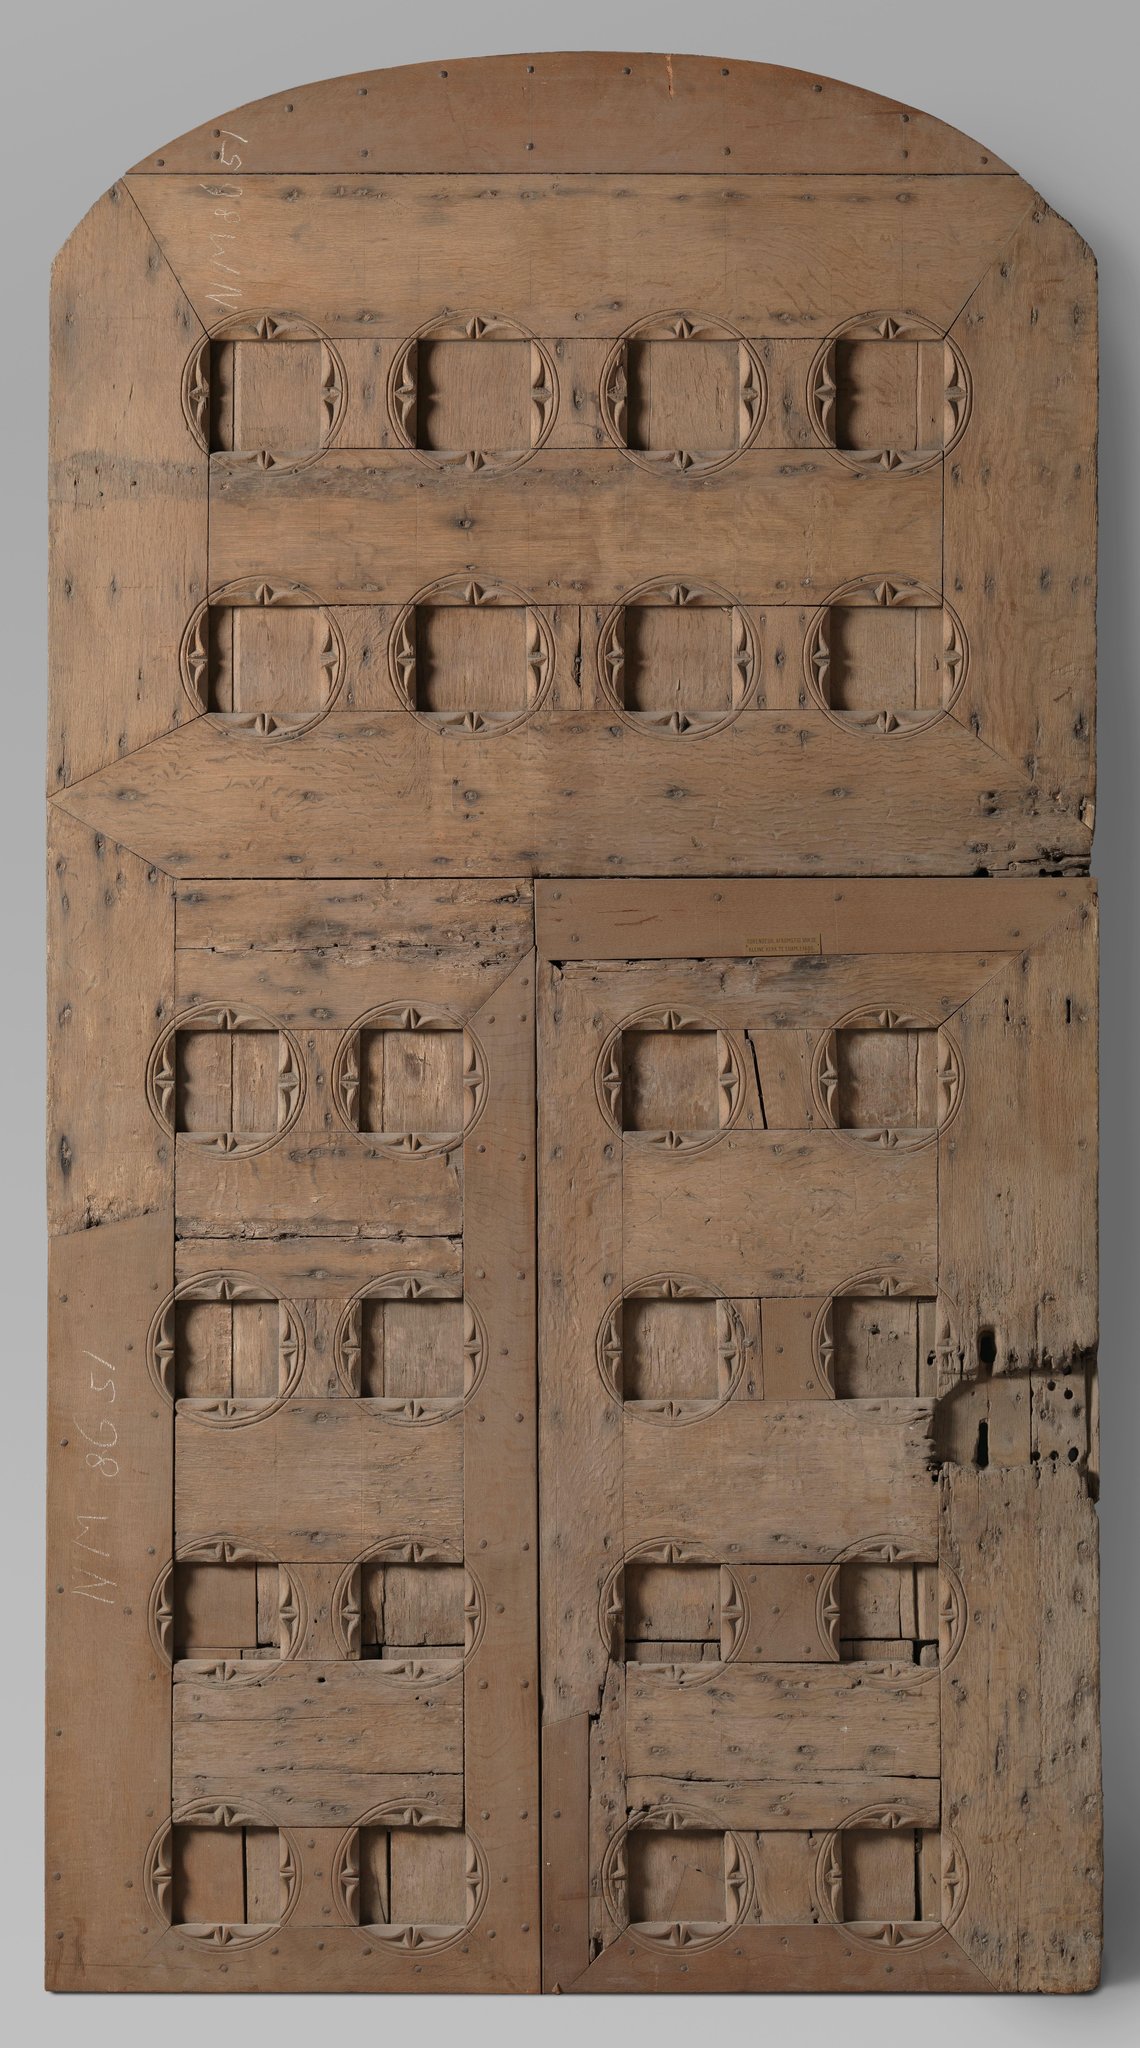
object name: door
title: Torendeur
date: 1400-1950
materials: iron, wood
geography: edam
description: Een torendeur. Afkomstig van een van de poorten aan de kleine (of O.L. Vrouwe) kerk te Edam.